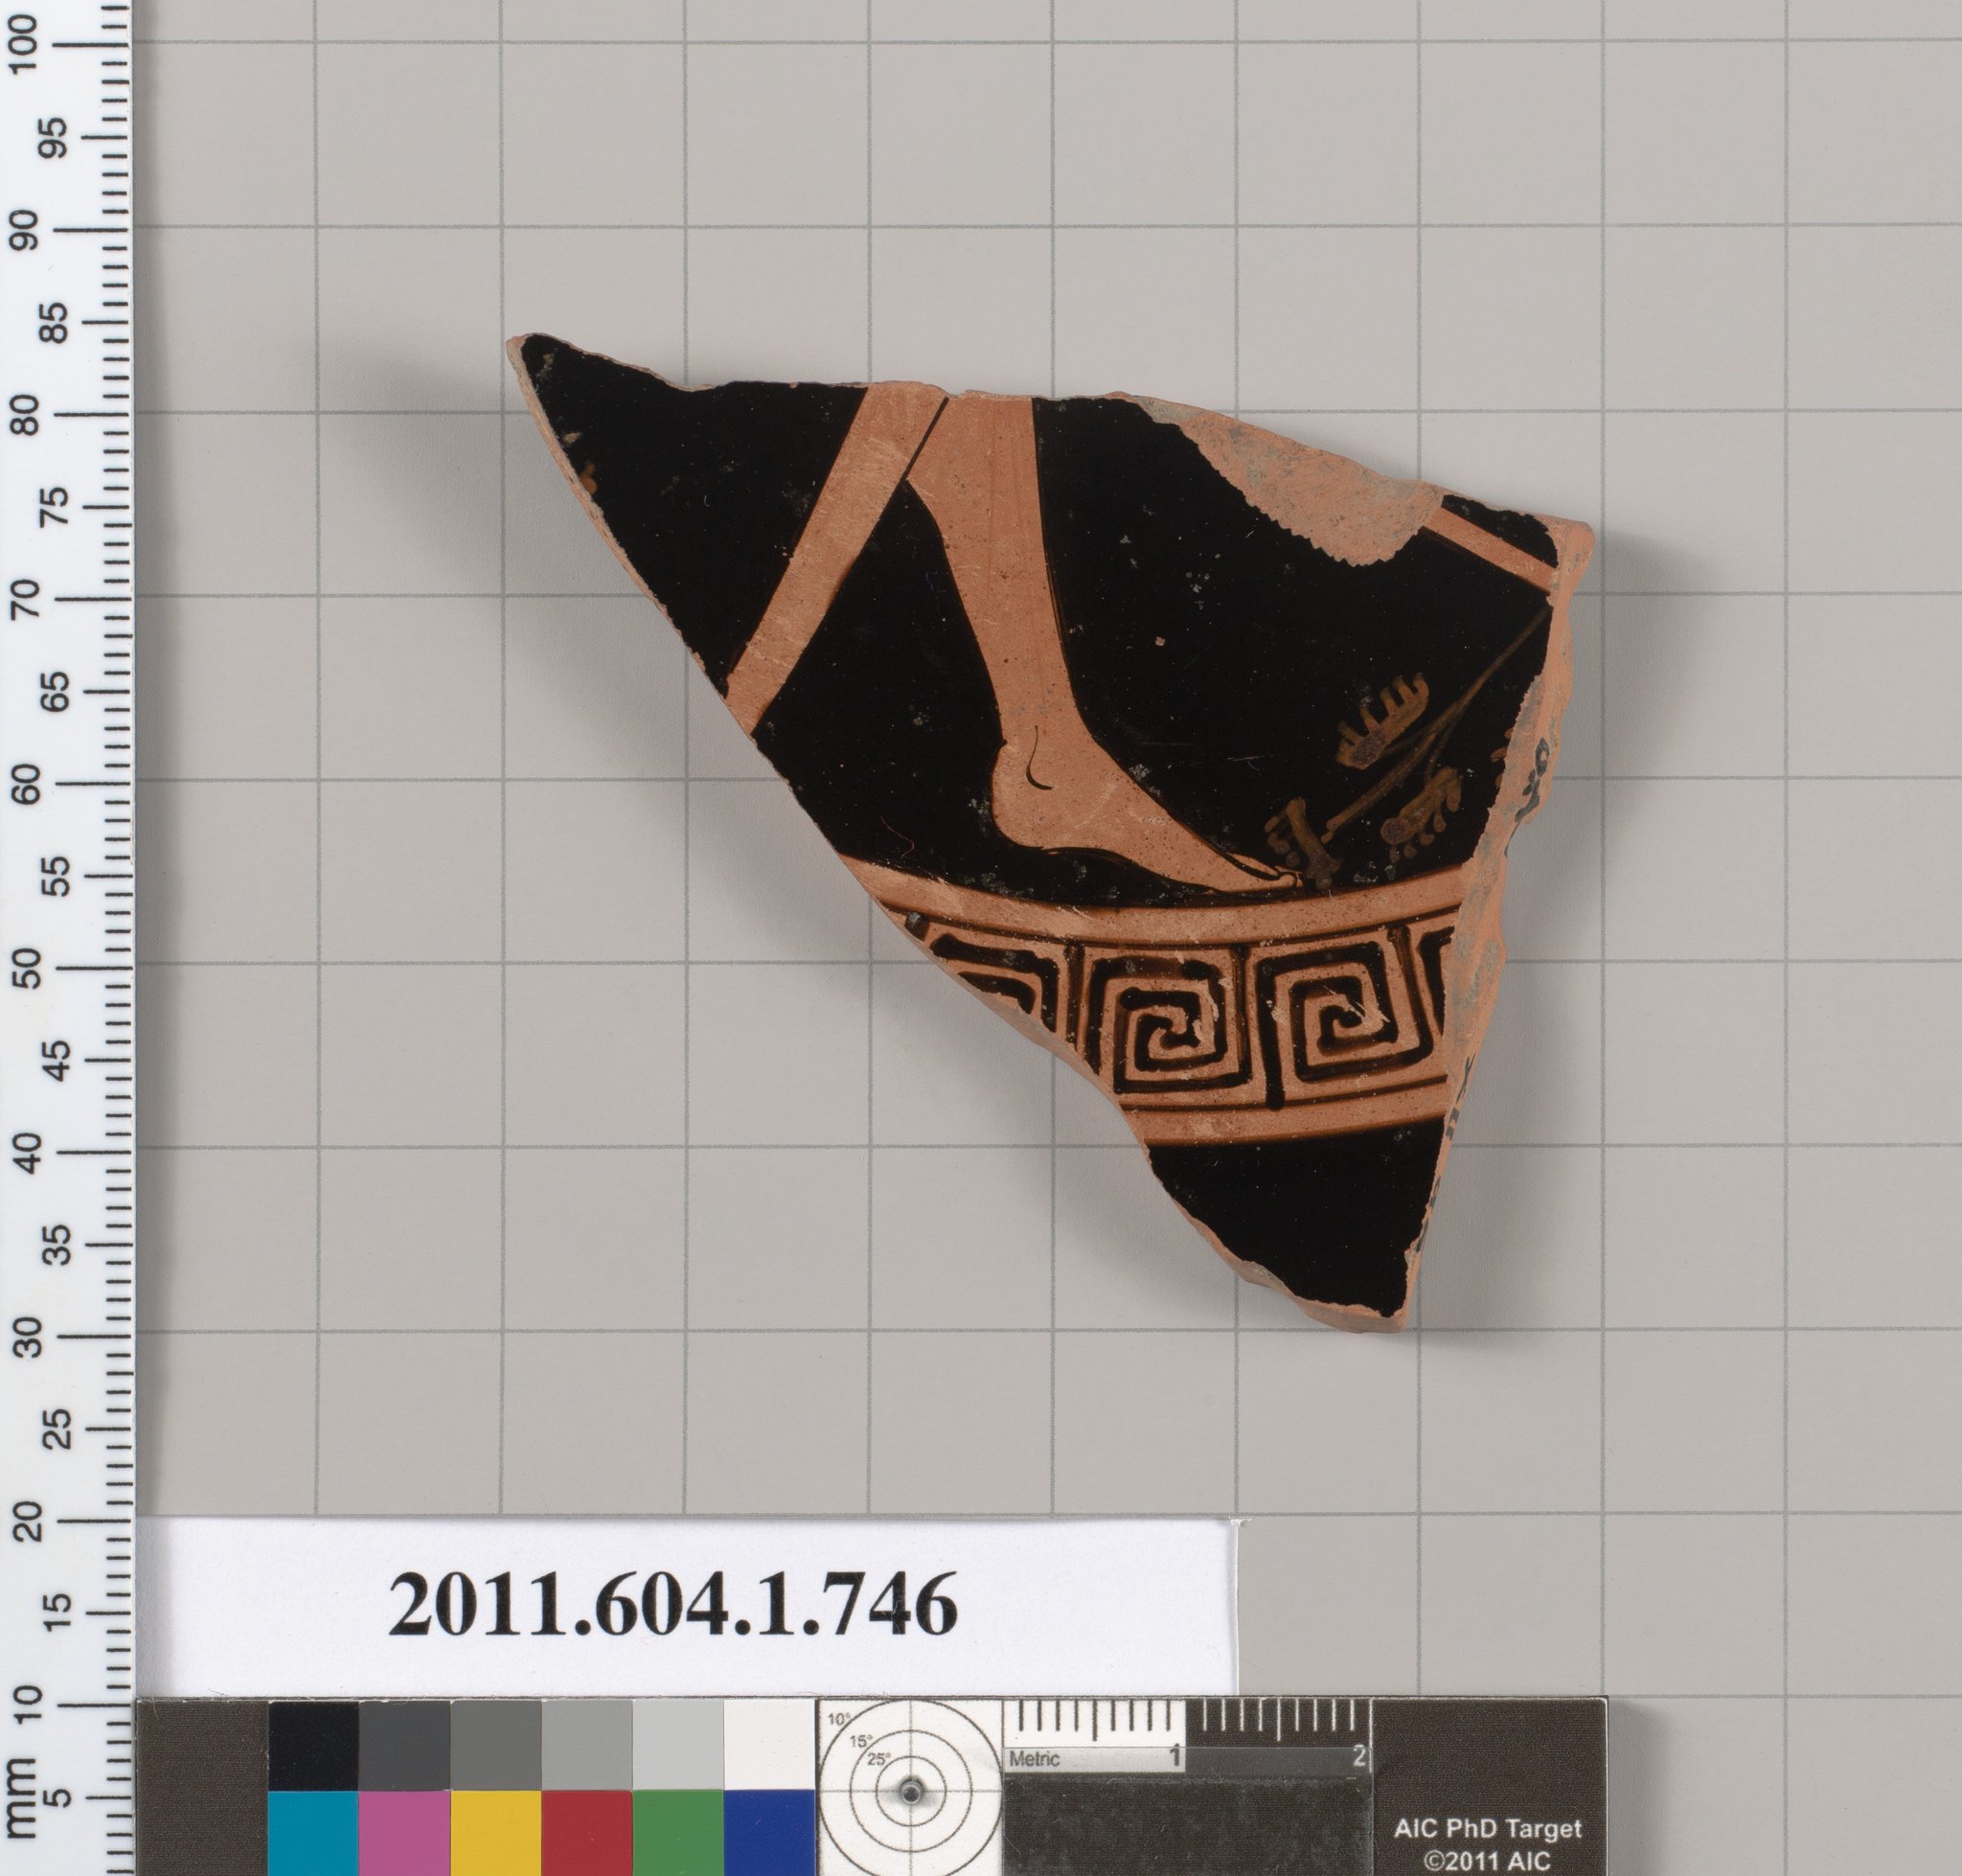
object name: kylix fragment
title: Terracotta fragment of a kylix (drinking cup)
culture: greek, attic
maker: foundry painter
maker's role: artist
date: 490-480 BCE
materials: terracotta